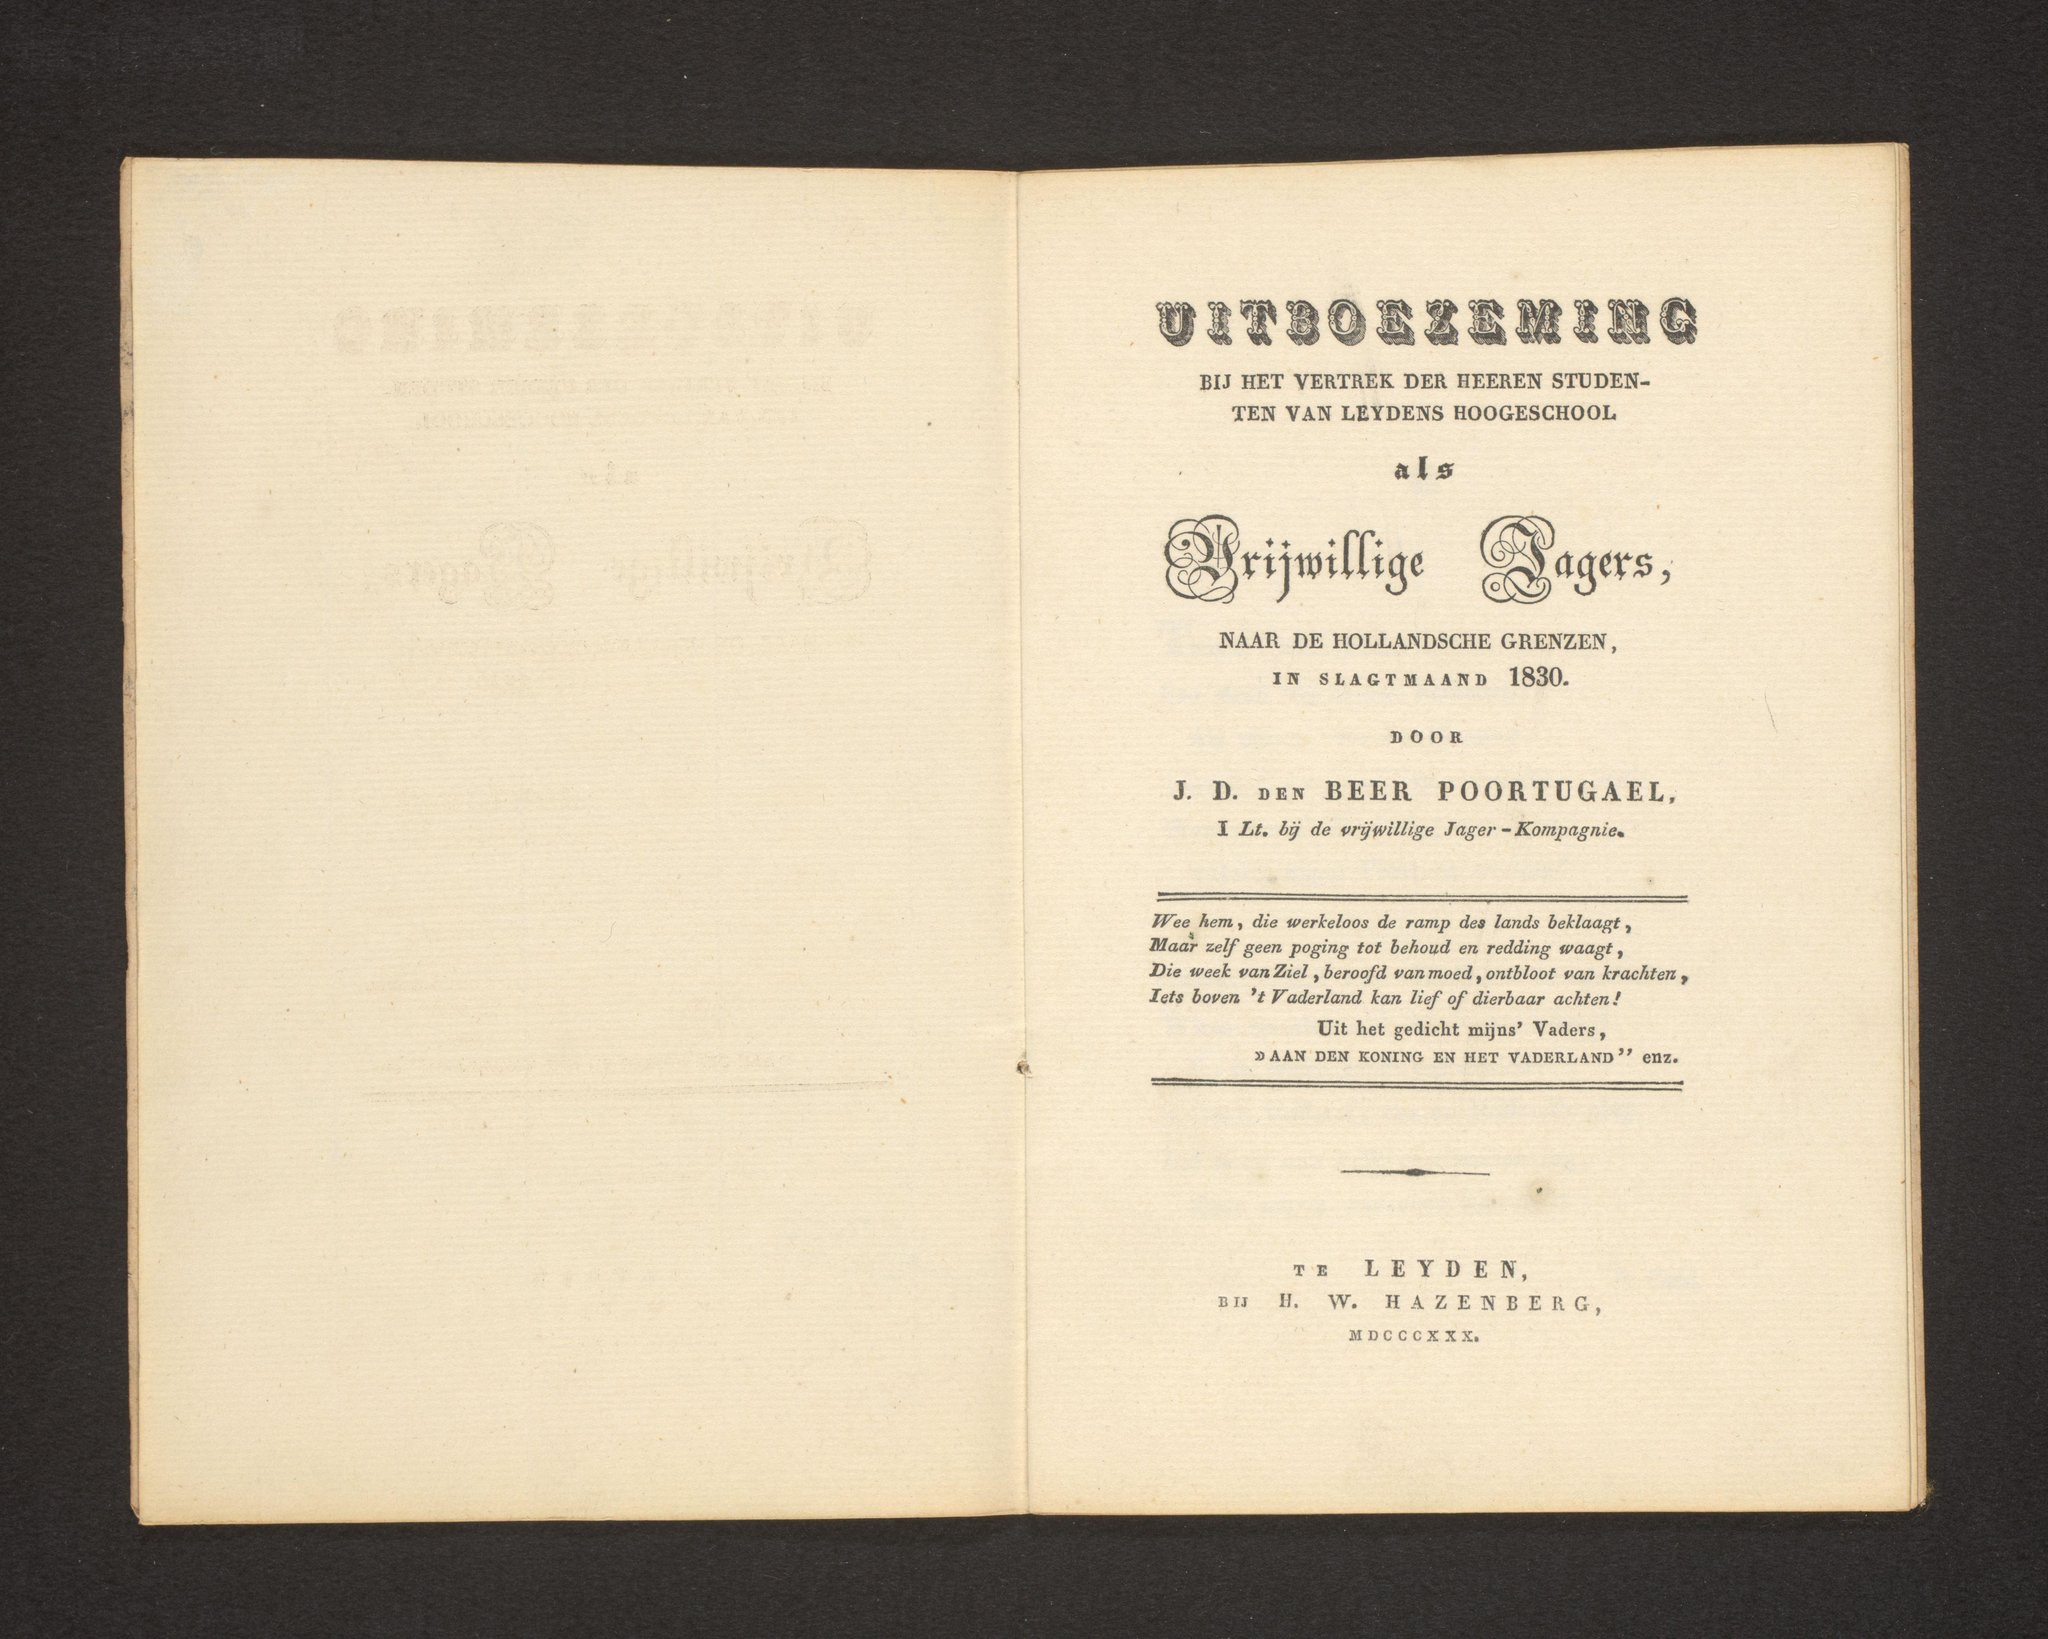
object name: brochure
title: Uitboezeming bij het vertrek der heeren studenten van Leydens Hoogeschool als Vrijwillige Jagers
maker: diederik jacobus den beer poortugael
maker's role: dichter, officier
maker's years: 1800-1879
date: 1830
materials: paper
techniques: printing, sewing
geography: leiden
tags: leiden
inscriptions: date